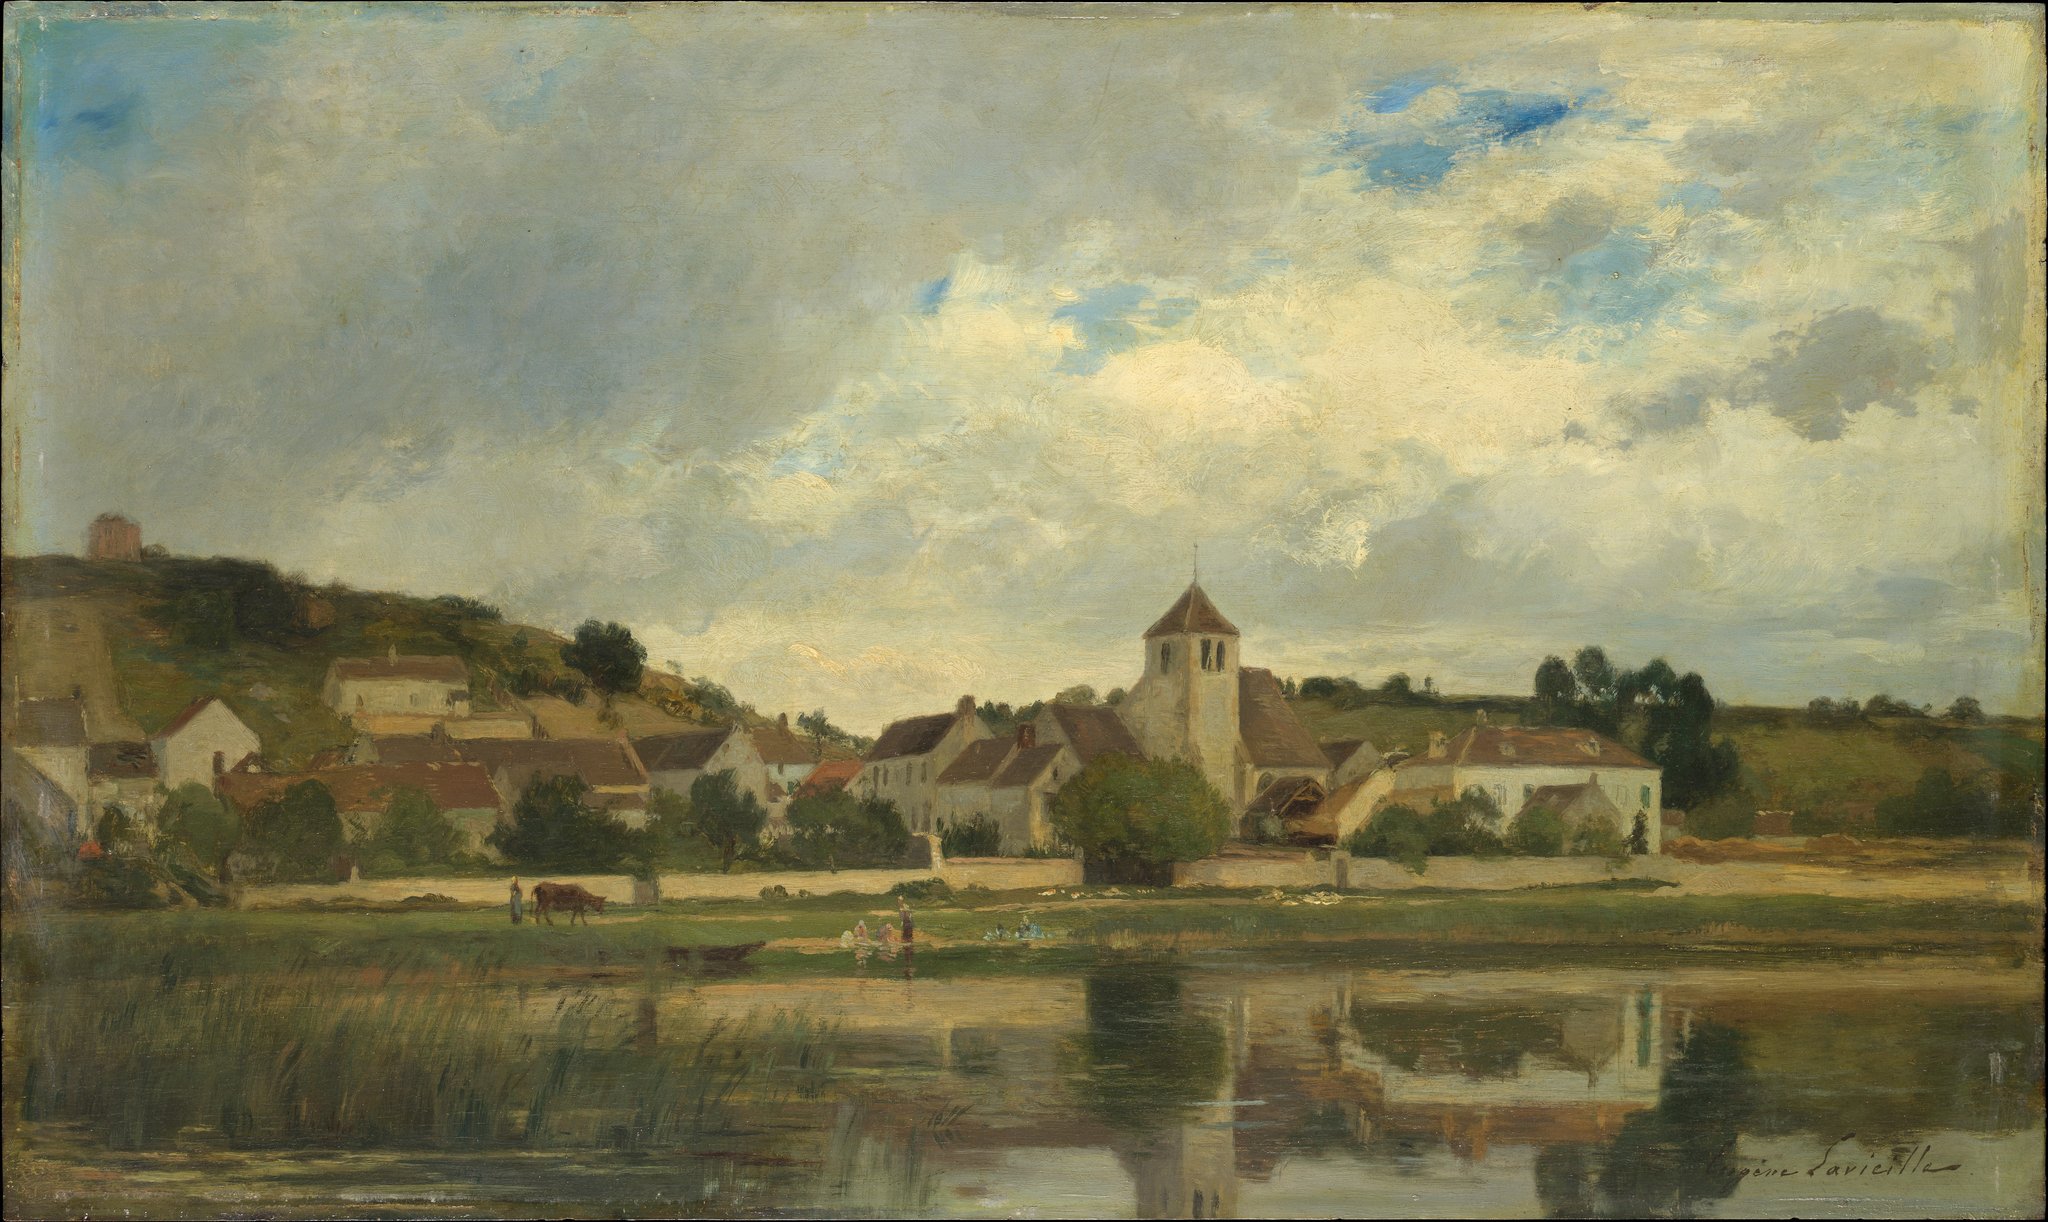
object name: painting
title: The Village of La Celle-sous-Moret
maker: eugène lavieille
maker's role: artist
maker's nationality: french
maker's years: 1820-1889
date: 1840-1889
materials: oil, wood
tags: villages,landscapes